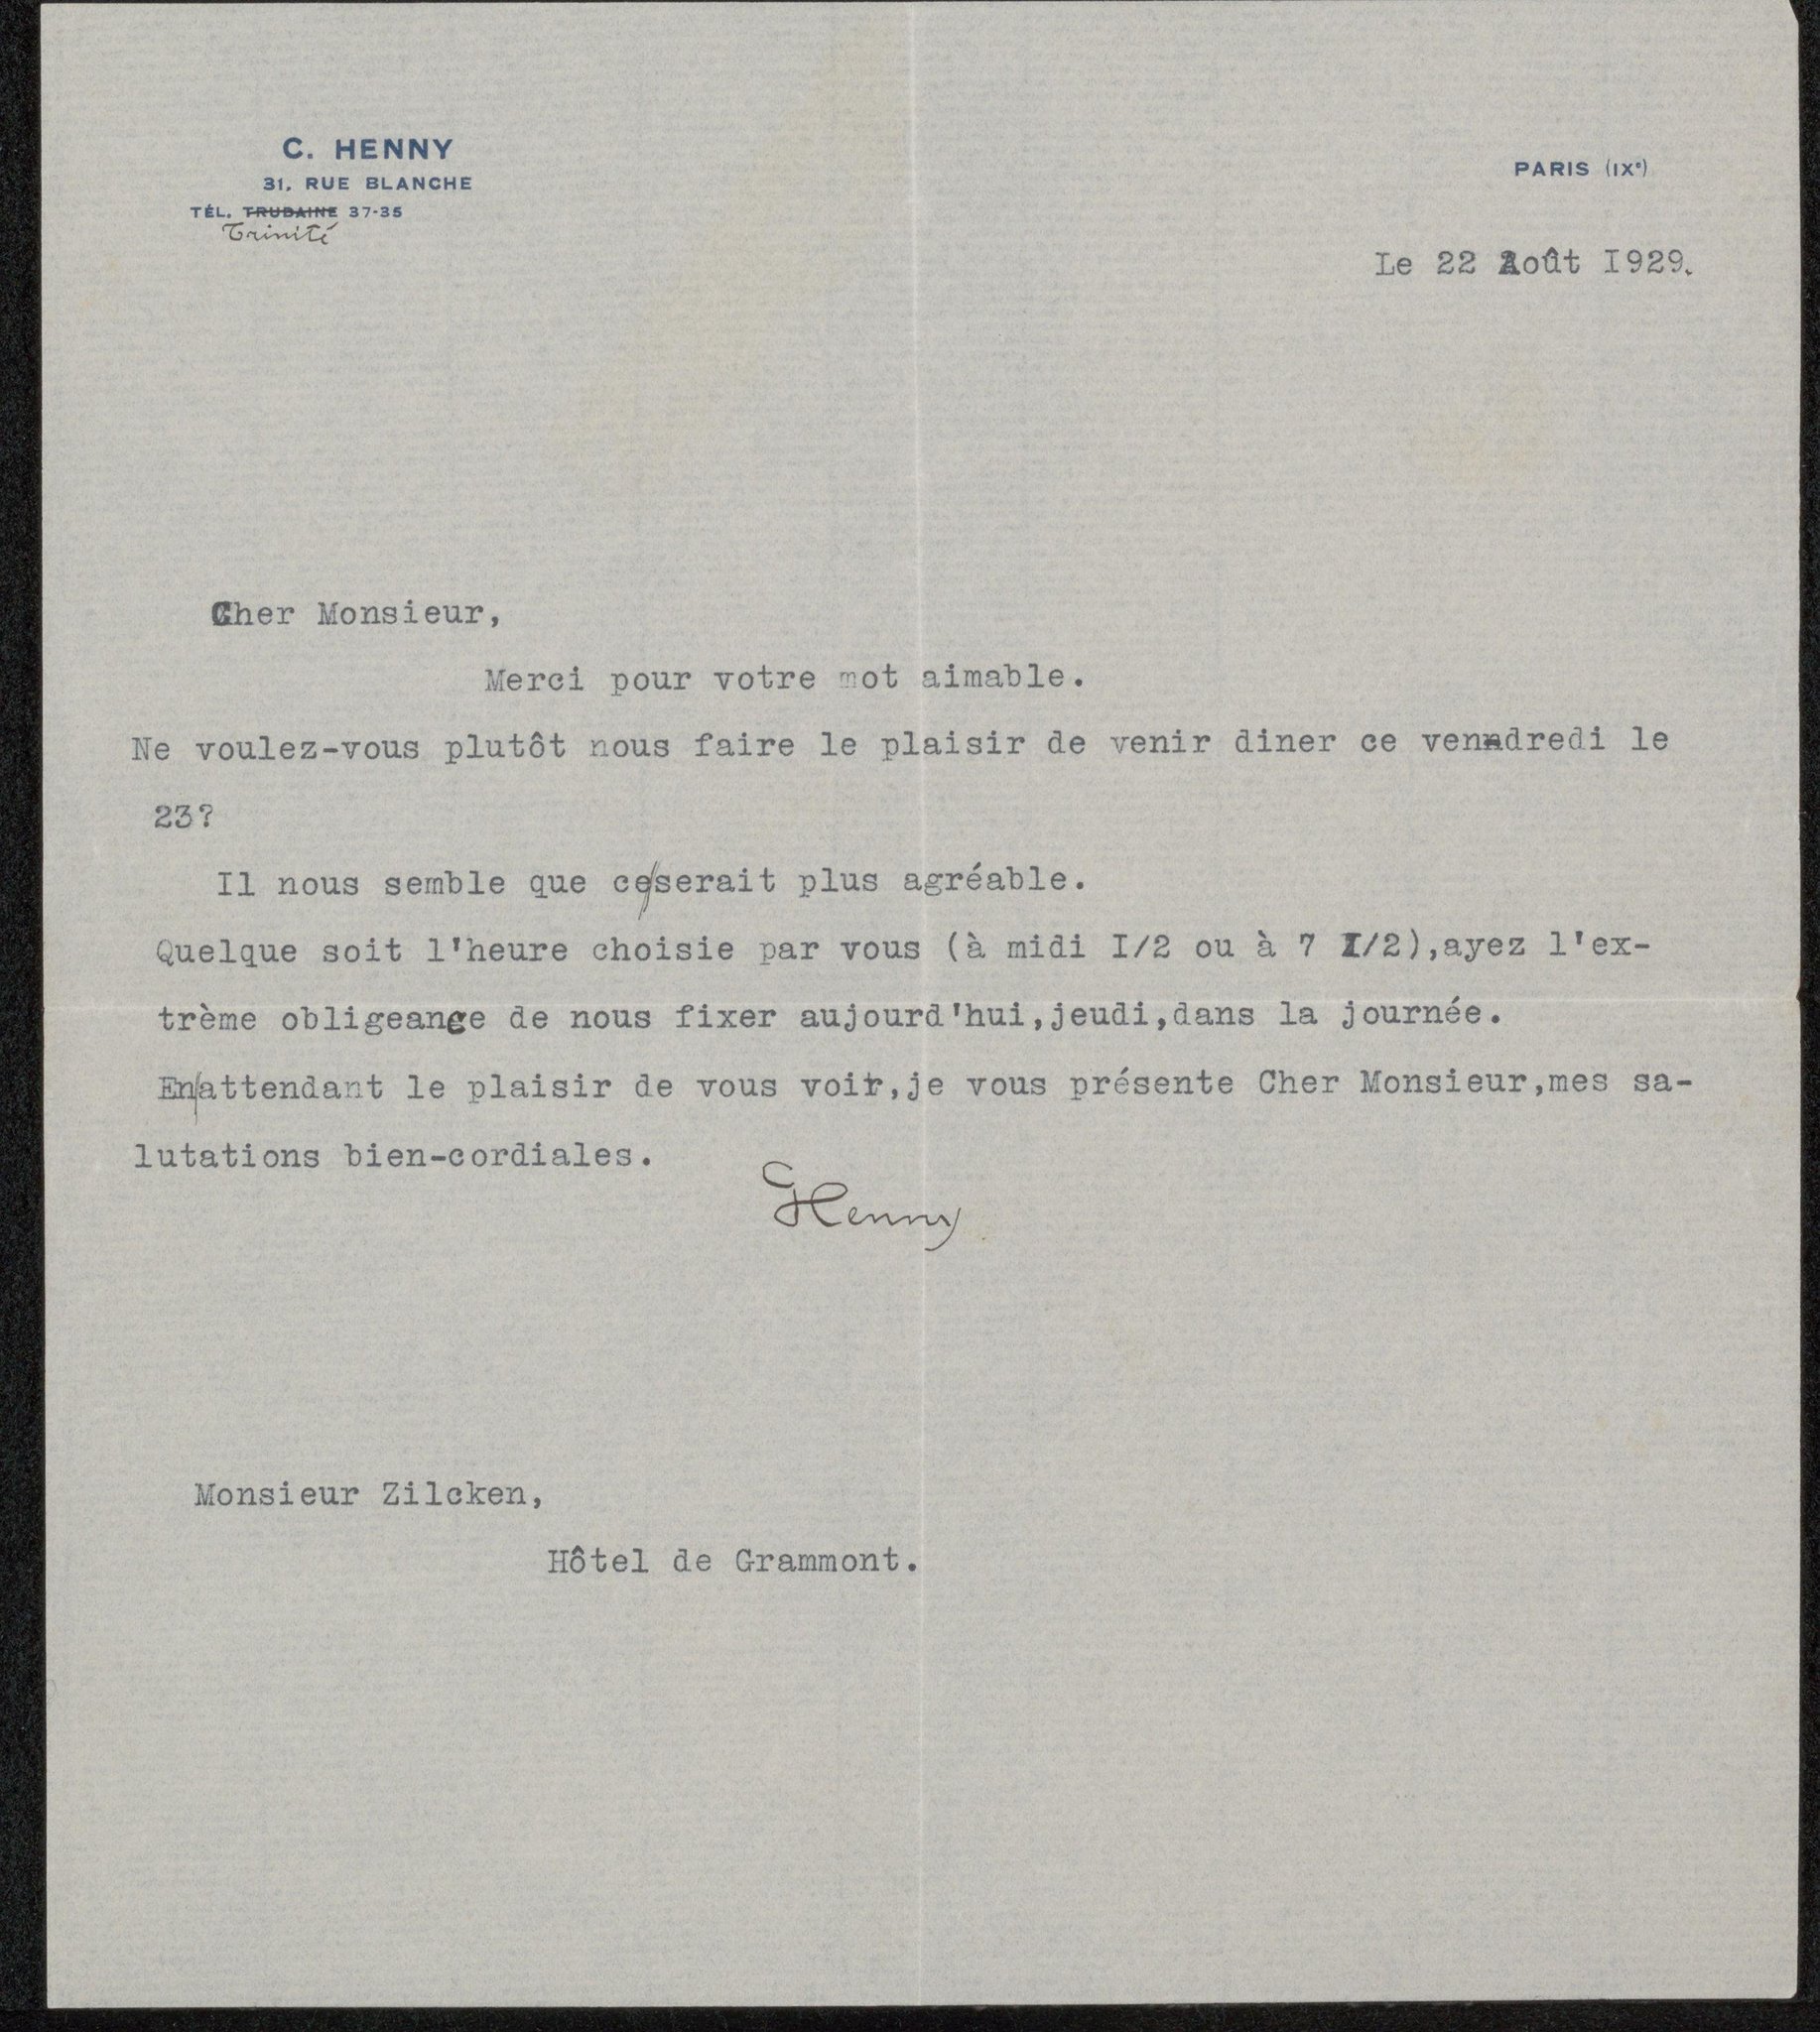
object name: letter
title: Brief aan Philip Zilcken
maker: carl henny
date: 1929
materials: ink, paper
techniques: pen, printing, typewriting, writing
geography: paris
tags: the hague, painter, draughtsman, philip zilcken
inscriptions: collector's mark: ‘RPK’